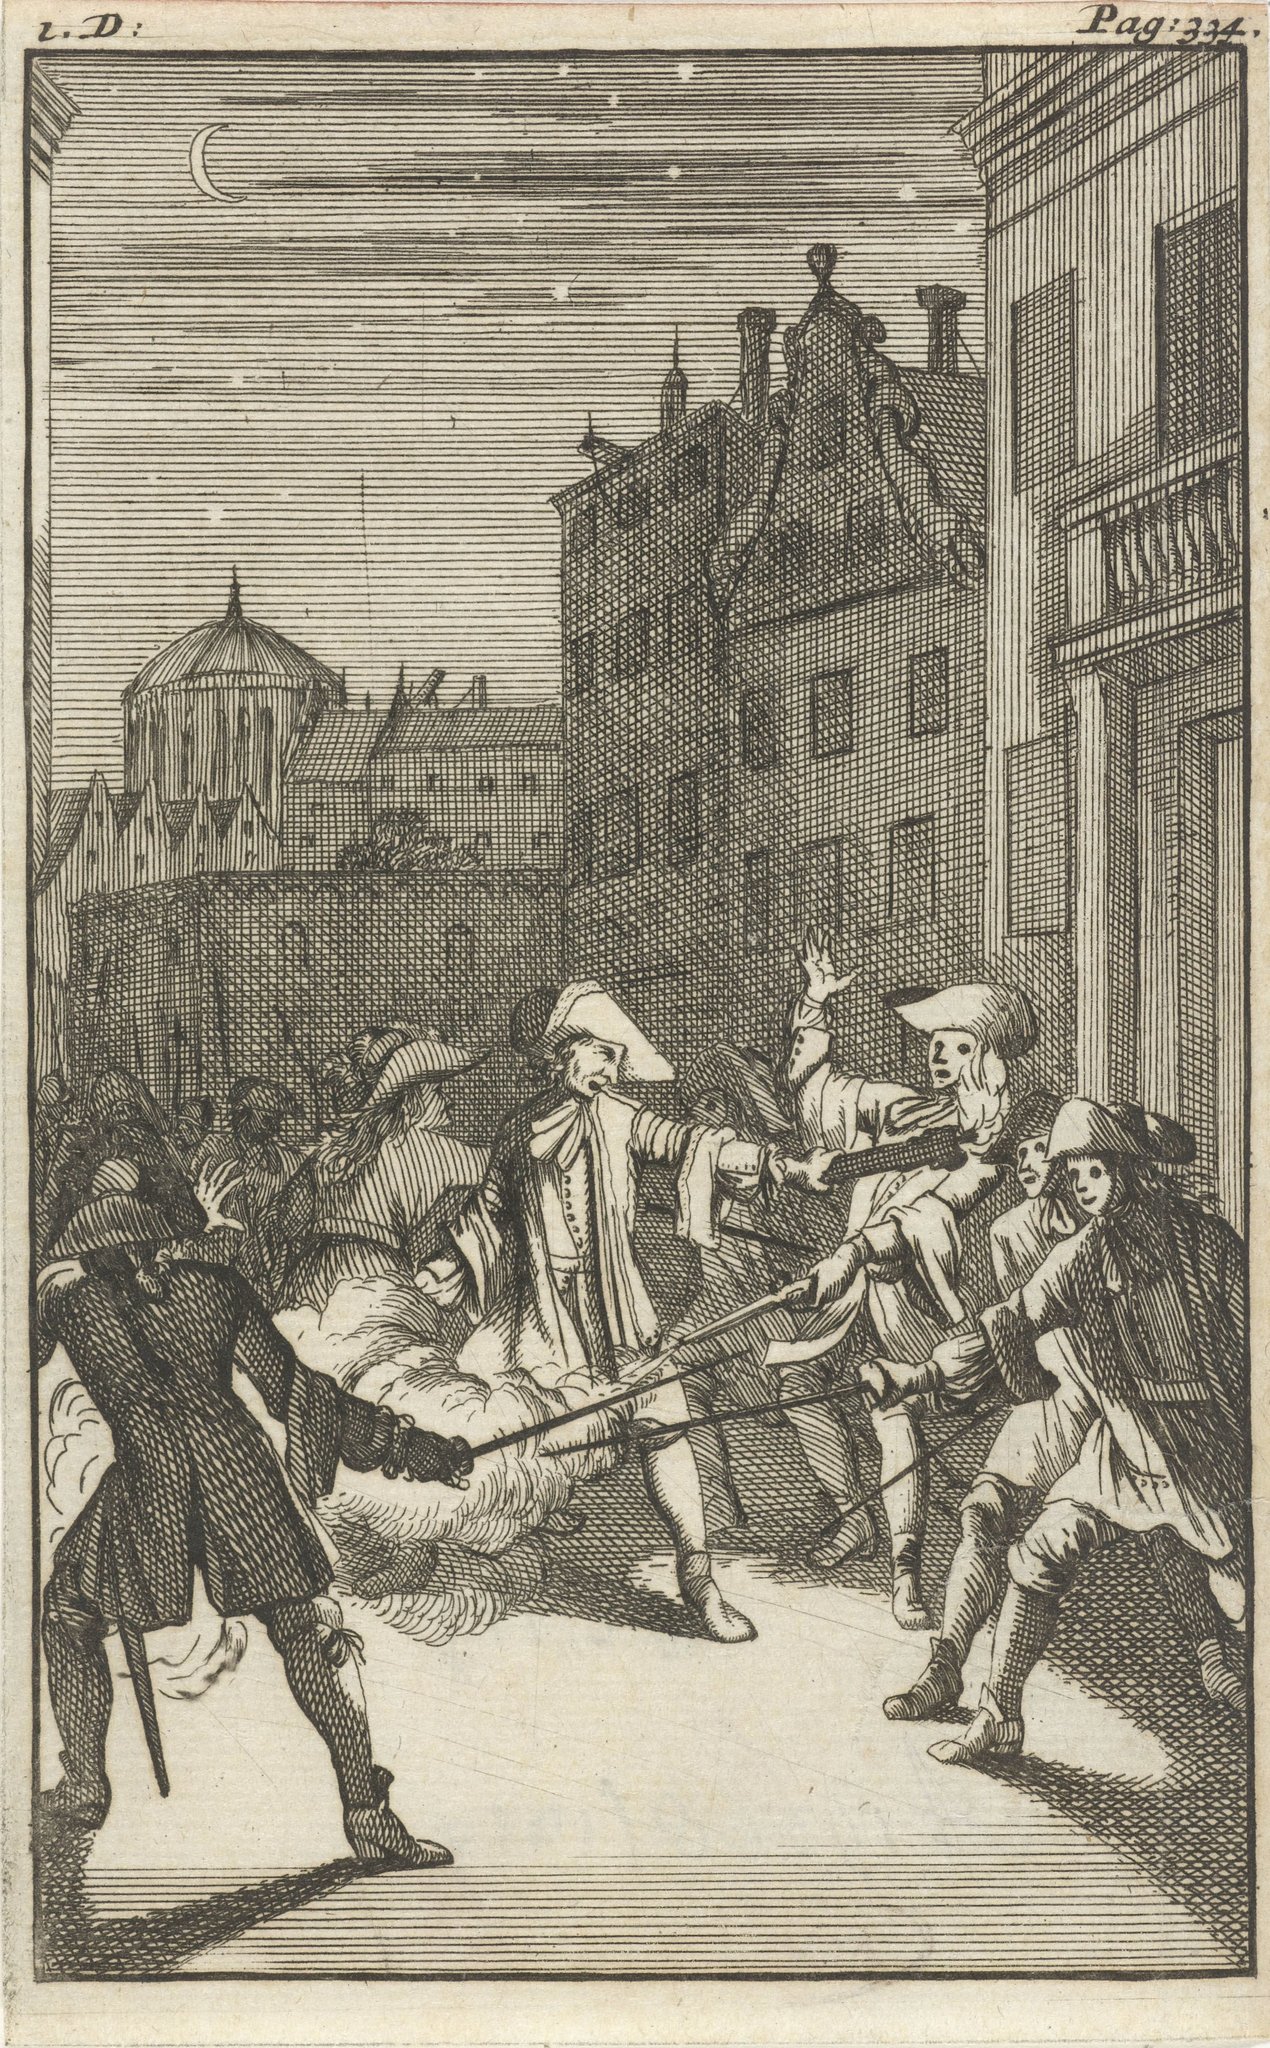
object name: book illustration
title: Mirandor en Belindor te Parijs op straat door vermomde mannen aangevallen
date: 1695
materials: paper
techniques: etching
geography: amsterdam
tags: being attacked; defence, paris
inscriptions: collector's mark: Lugt 2228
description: Illustratie uit: Heinsius, Nicolaas jr. Den vermakelyken avanturier, ofte De wispelturige, en niet min wonderlyke levens-loop van Mirandor, 2 delen. Amsterdam: Pieter van Amsterdam, 1695, dl. I.